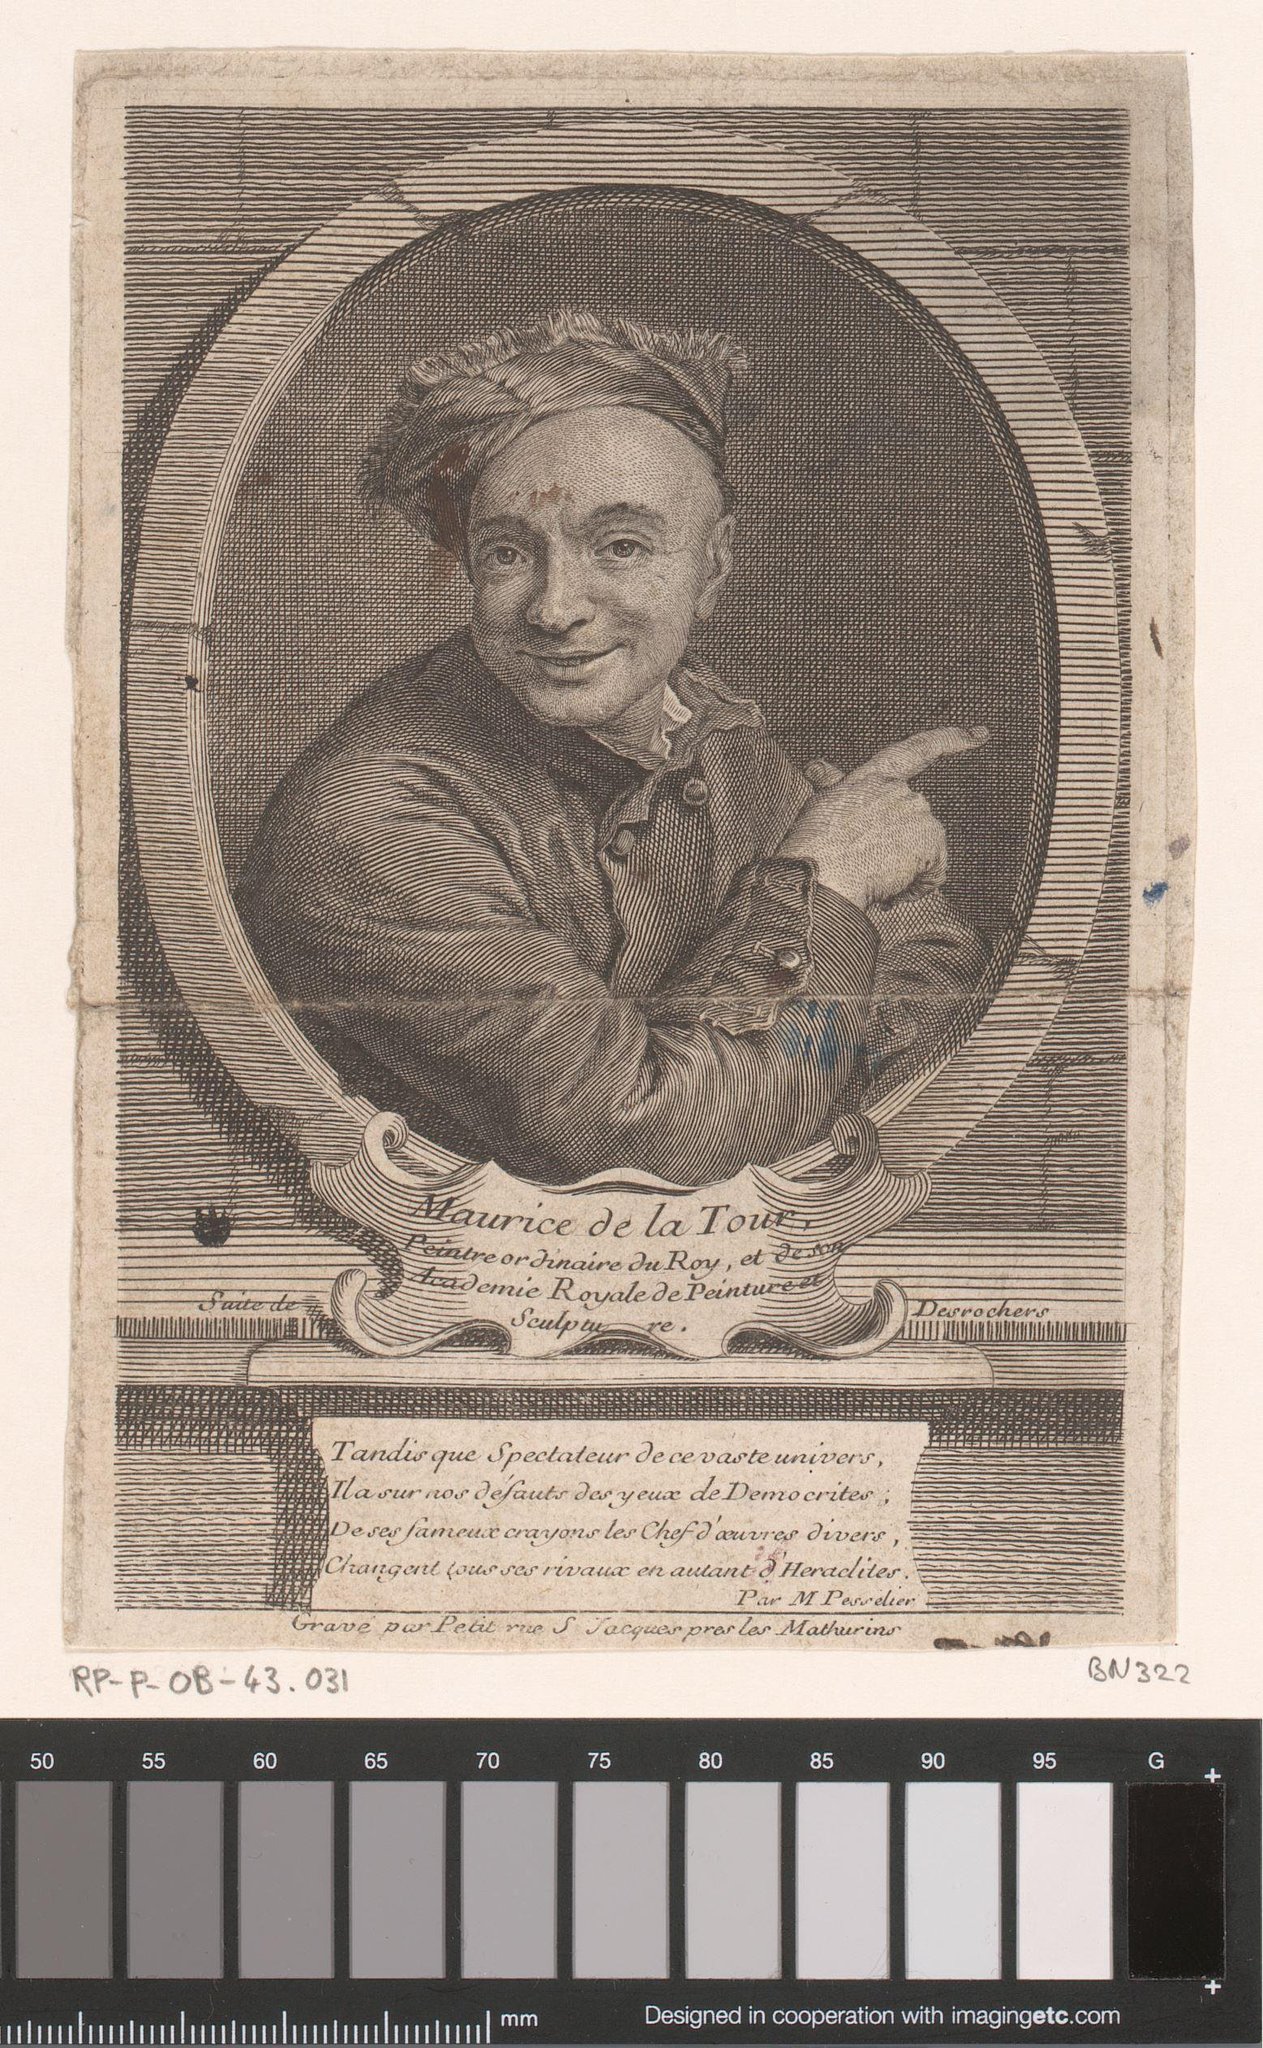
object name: print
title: Recueil de portraits (...)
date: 1726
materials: paper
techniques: engraving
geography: paris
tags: painter, maurice-quentin de la tour, historical persons, portrait, self-portrait of artist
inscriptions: collector's mark: Lugt 2228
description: Behoort waarschijnlijk tot een serie portretten, grotendeels door Etienne Desrochers, getiteld: 'Recueil de portraits de personnes qui se sont distinguées tant dans les Armes que dans Belles-Lettres et les Arts, comme aussi la famille royale de France et autres cours étrangères'. De serie werd initieel uitgegeven door Desrochers en aangekondigd in 'Mercure' in mei 1726, p. 985. Echter was Desrochers reeds enkele jaren eerder begonnen met het uitgeven van de serie. Na de dood van Desrochers werd de serie voortgezet door Gilles Edme Petit. Een latere staat werd uitgegeven door Jean François Daumont in Parijs.